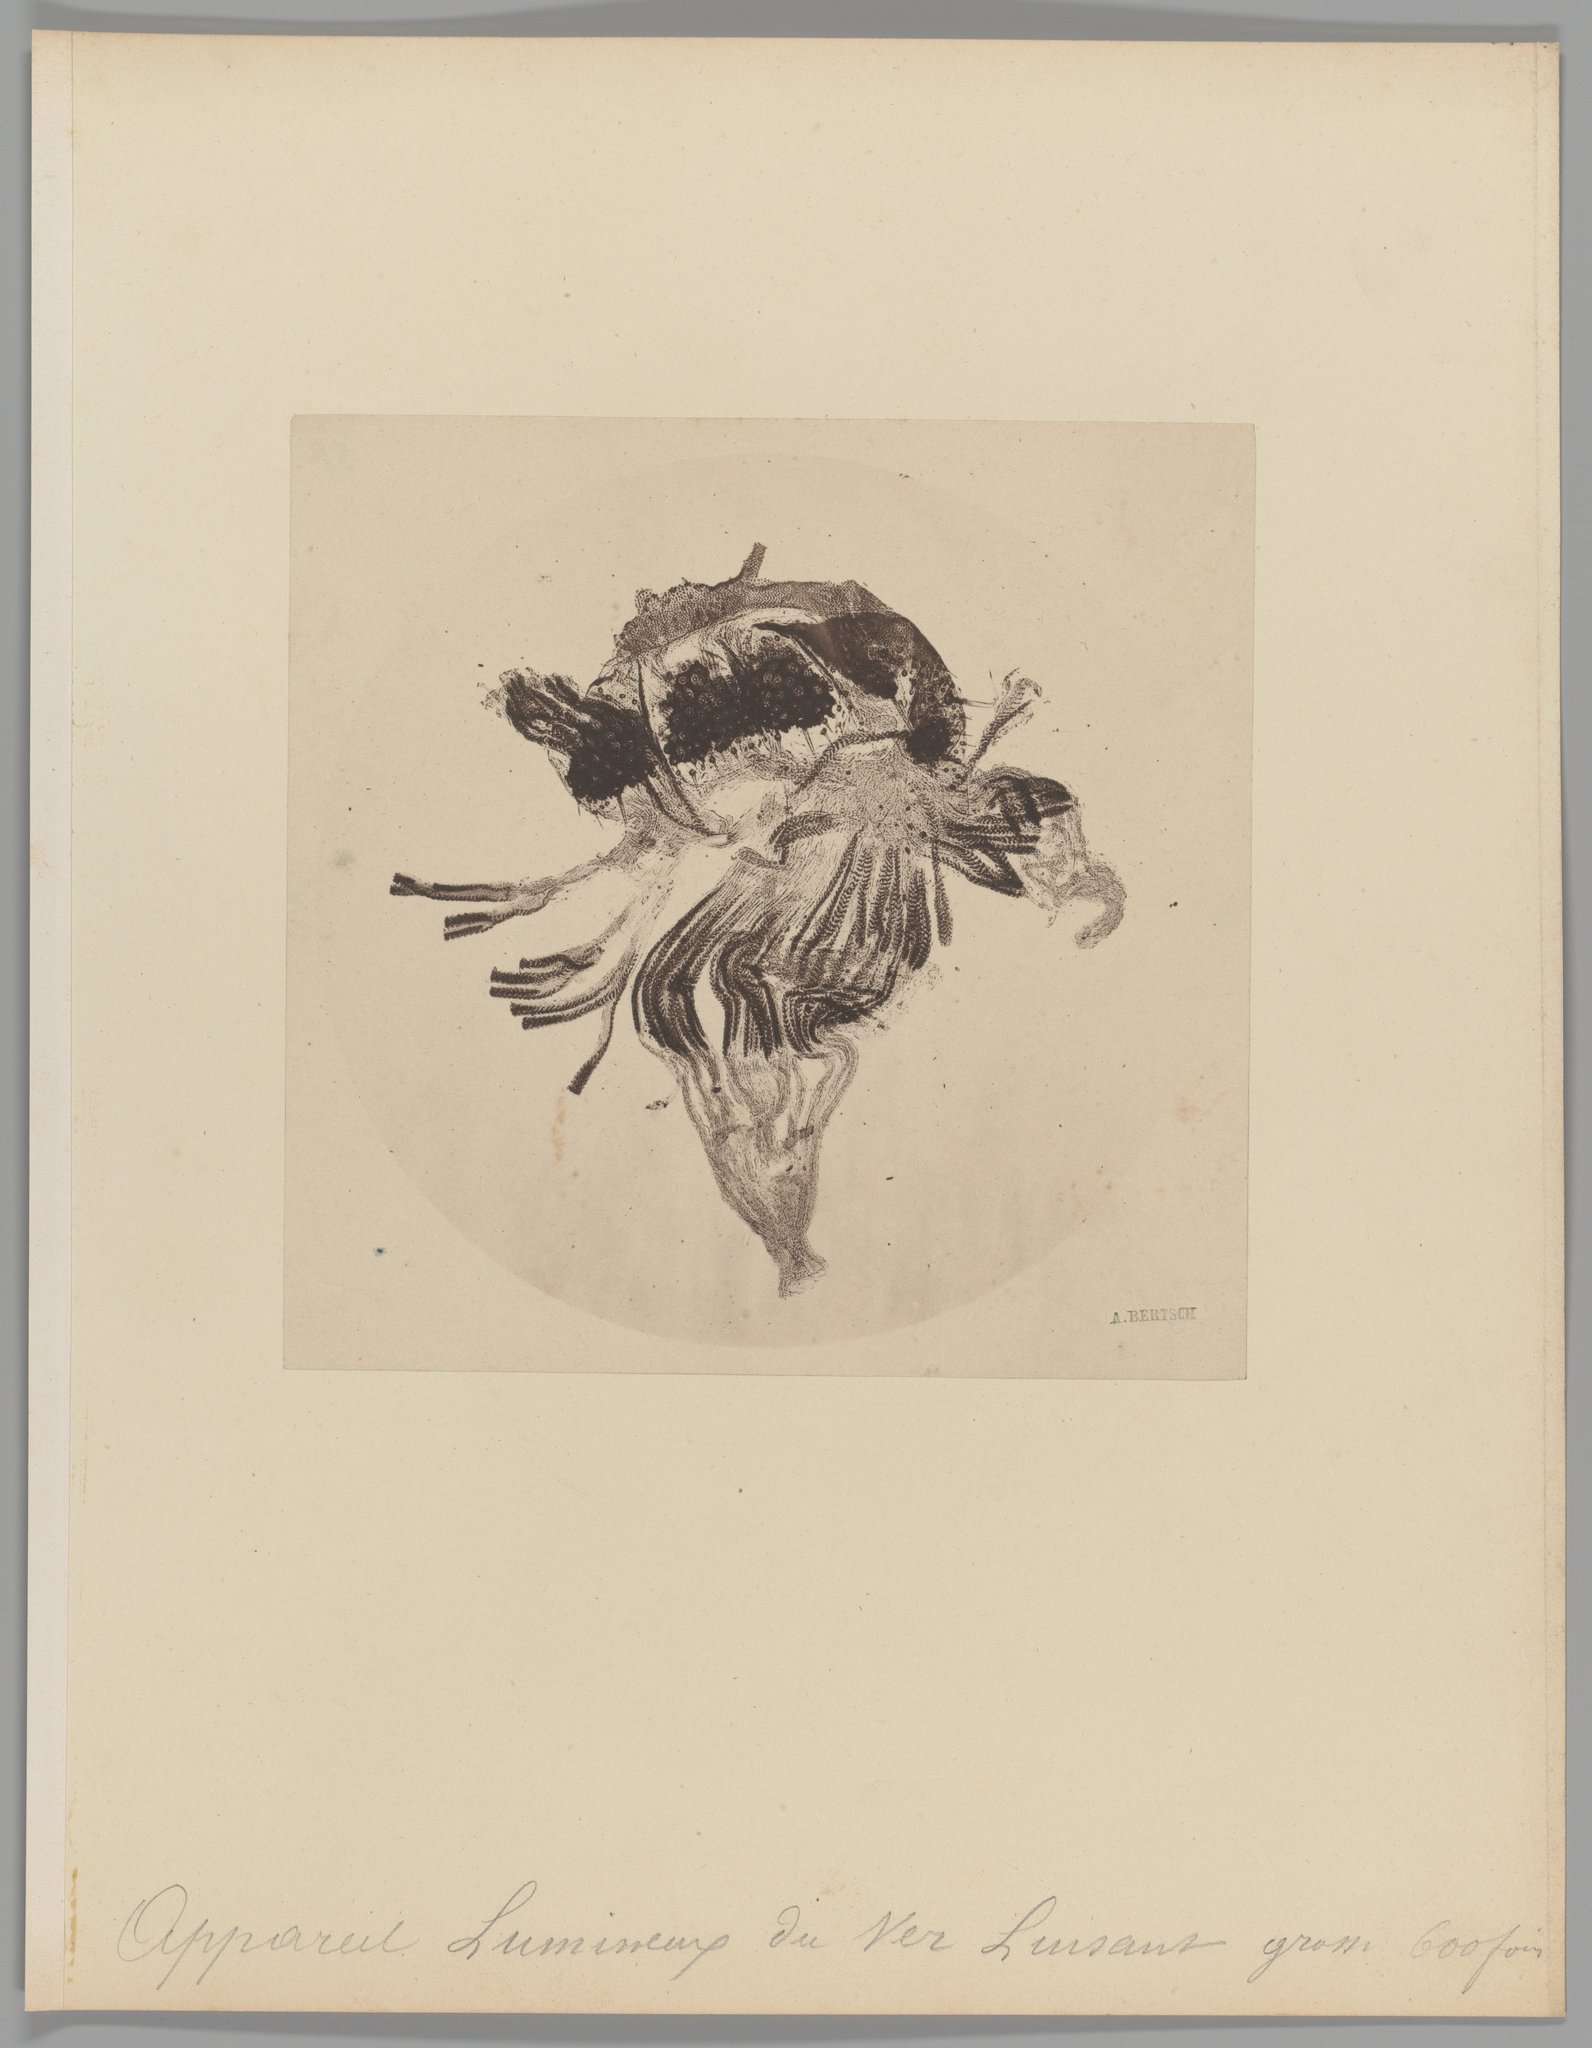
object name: photograph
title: [Untitled]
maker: auguste-adolphe bertsch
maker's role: artist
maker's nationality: french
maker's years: 1813-1871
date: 1853-1857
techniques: salted paper print